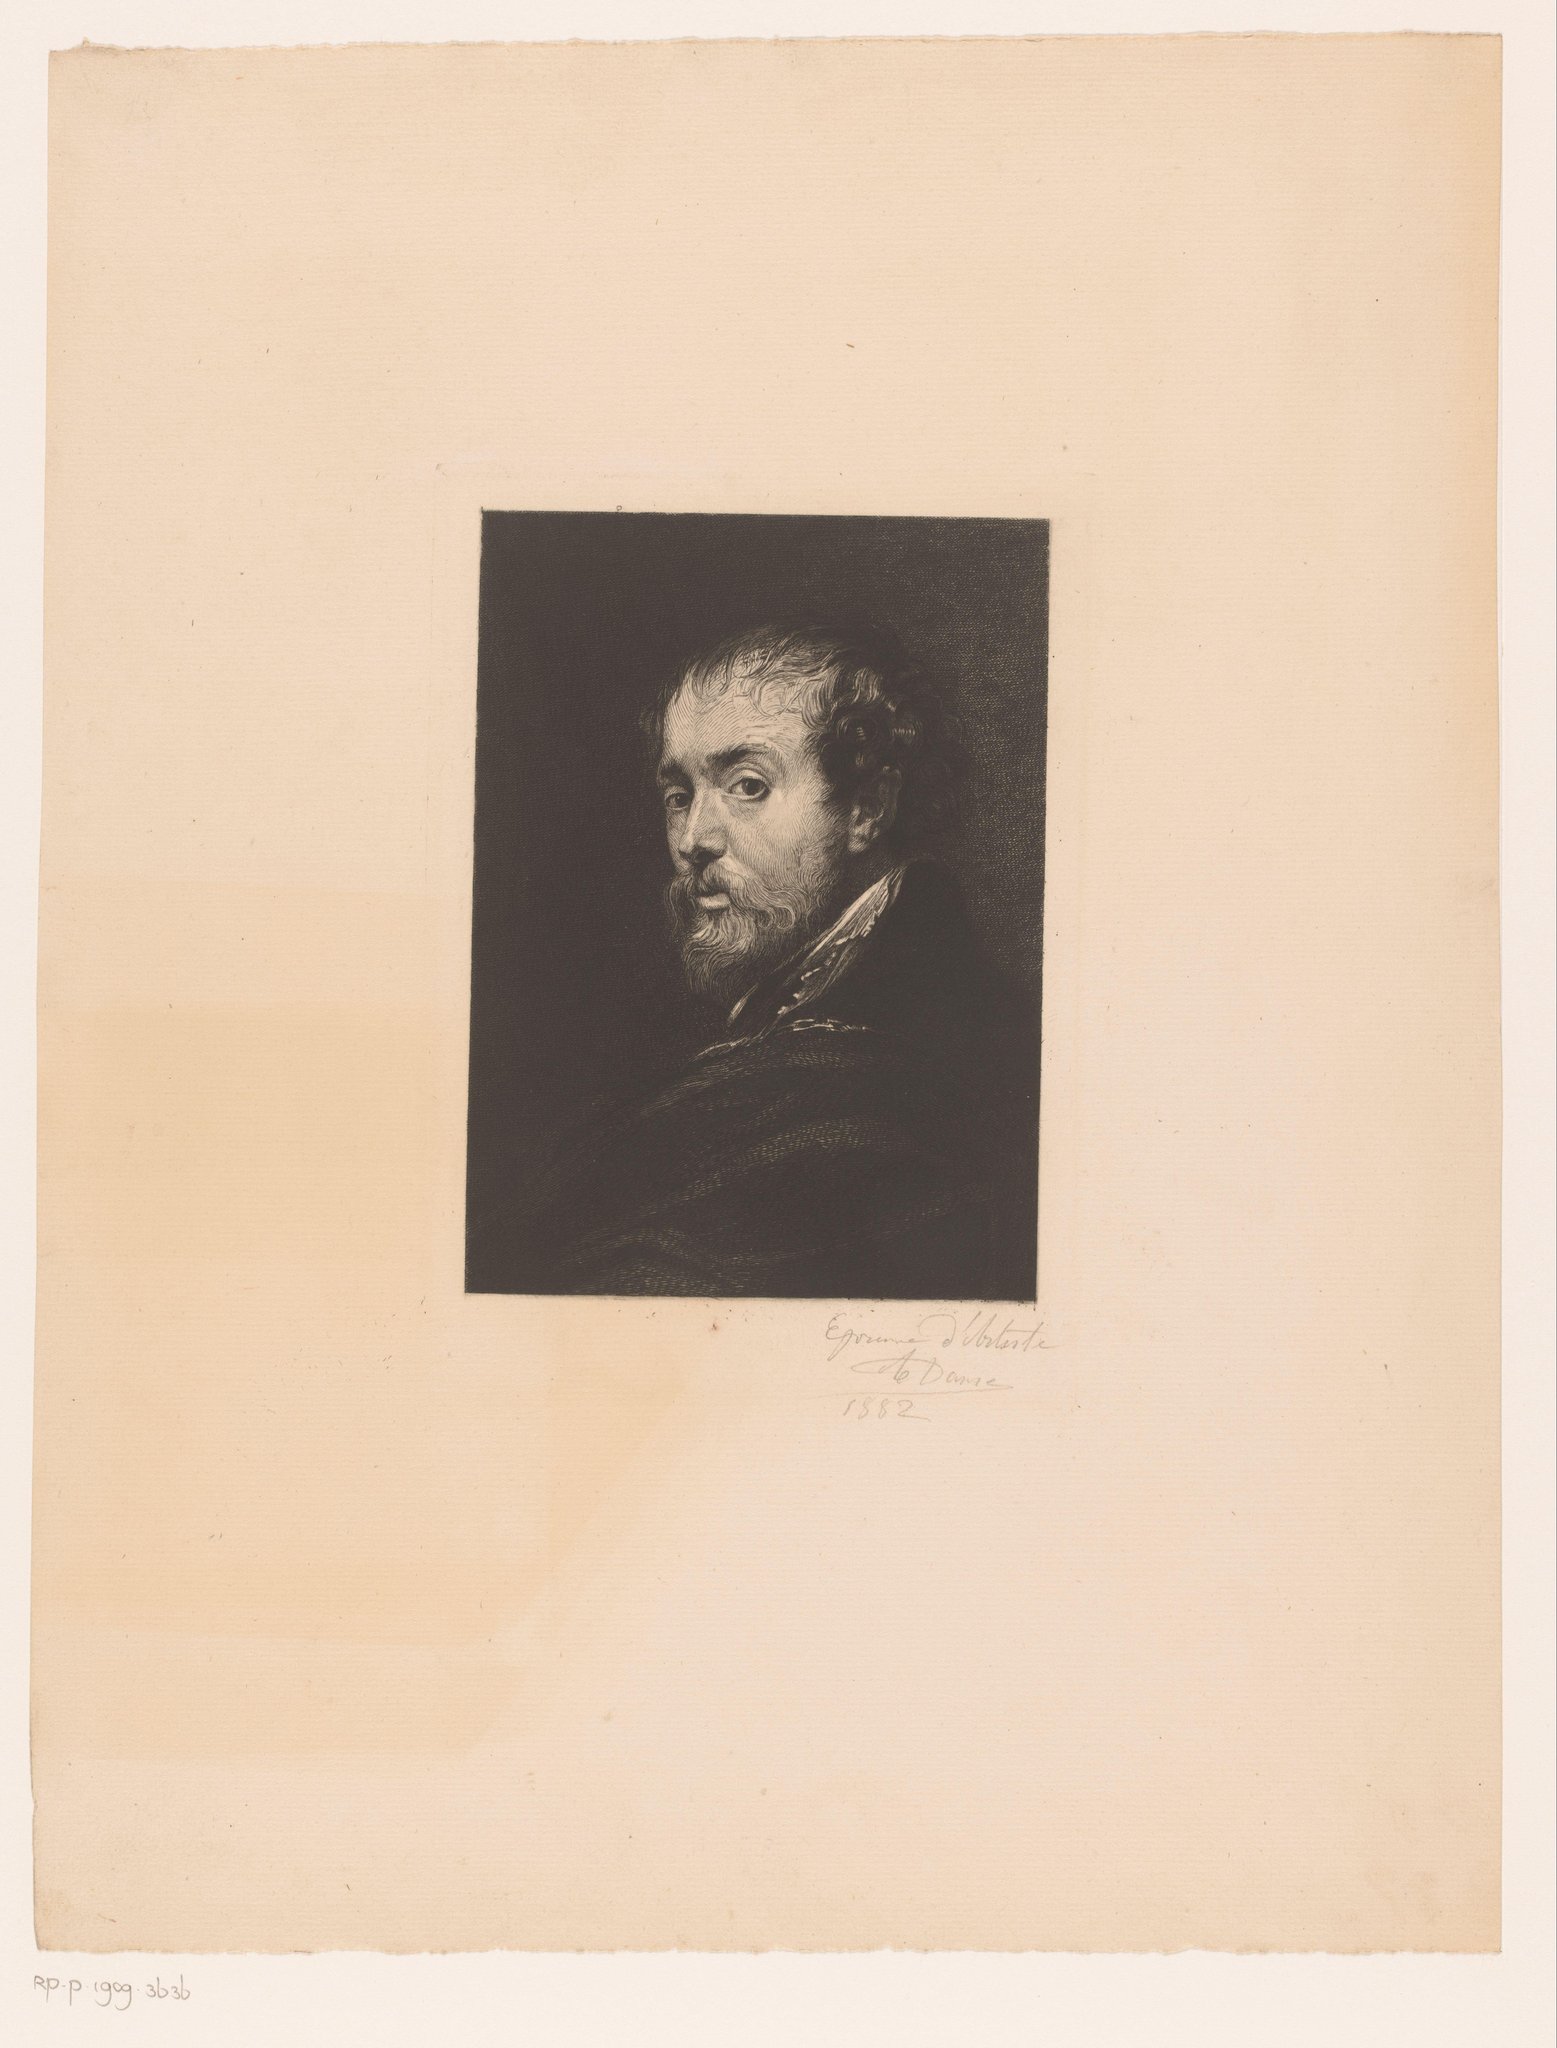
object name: print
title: Portret van Rubens, naar zijn zelfportret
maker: auguste danse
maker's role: print maker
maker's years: 1829-1929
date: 1882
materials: paper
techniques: drypoint, etching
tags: antwerp, painter, print maker, draughtsman, peter paul rubens, portrait, self-portrait of painter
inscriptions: annotation: ‘Epreuve d'Artiste’, collector's mark: Lugt 2228